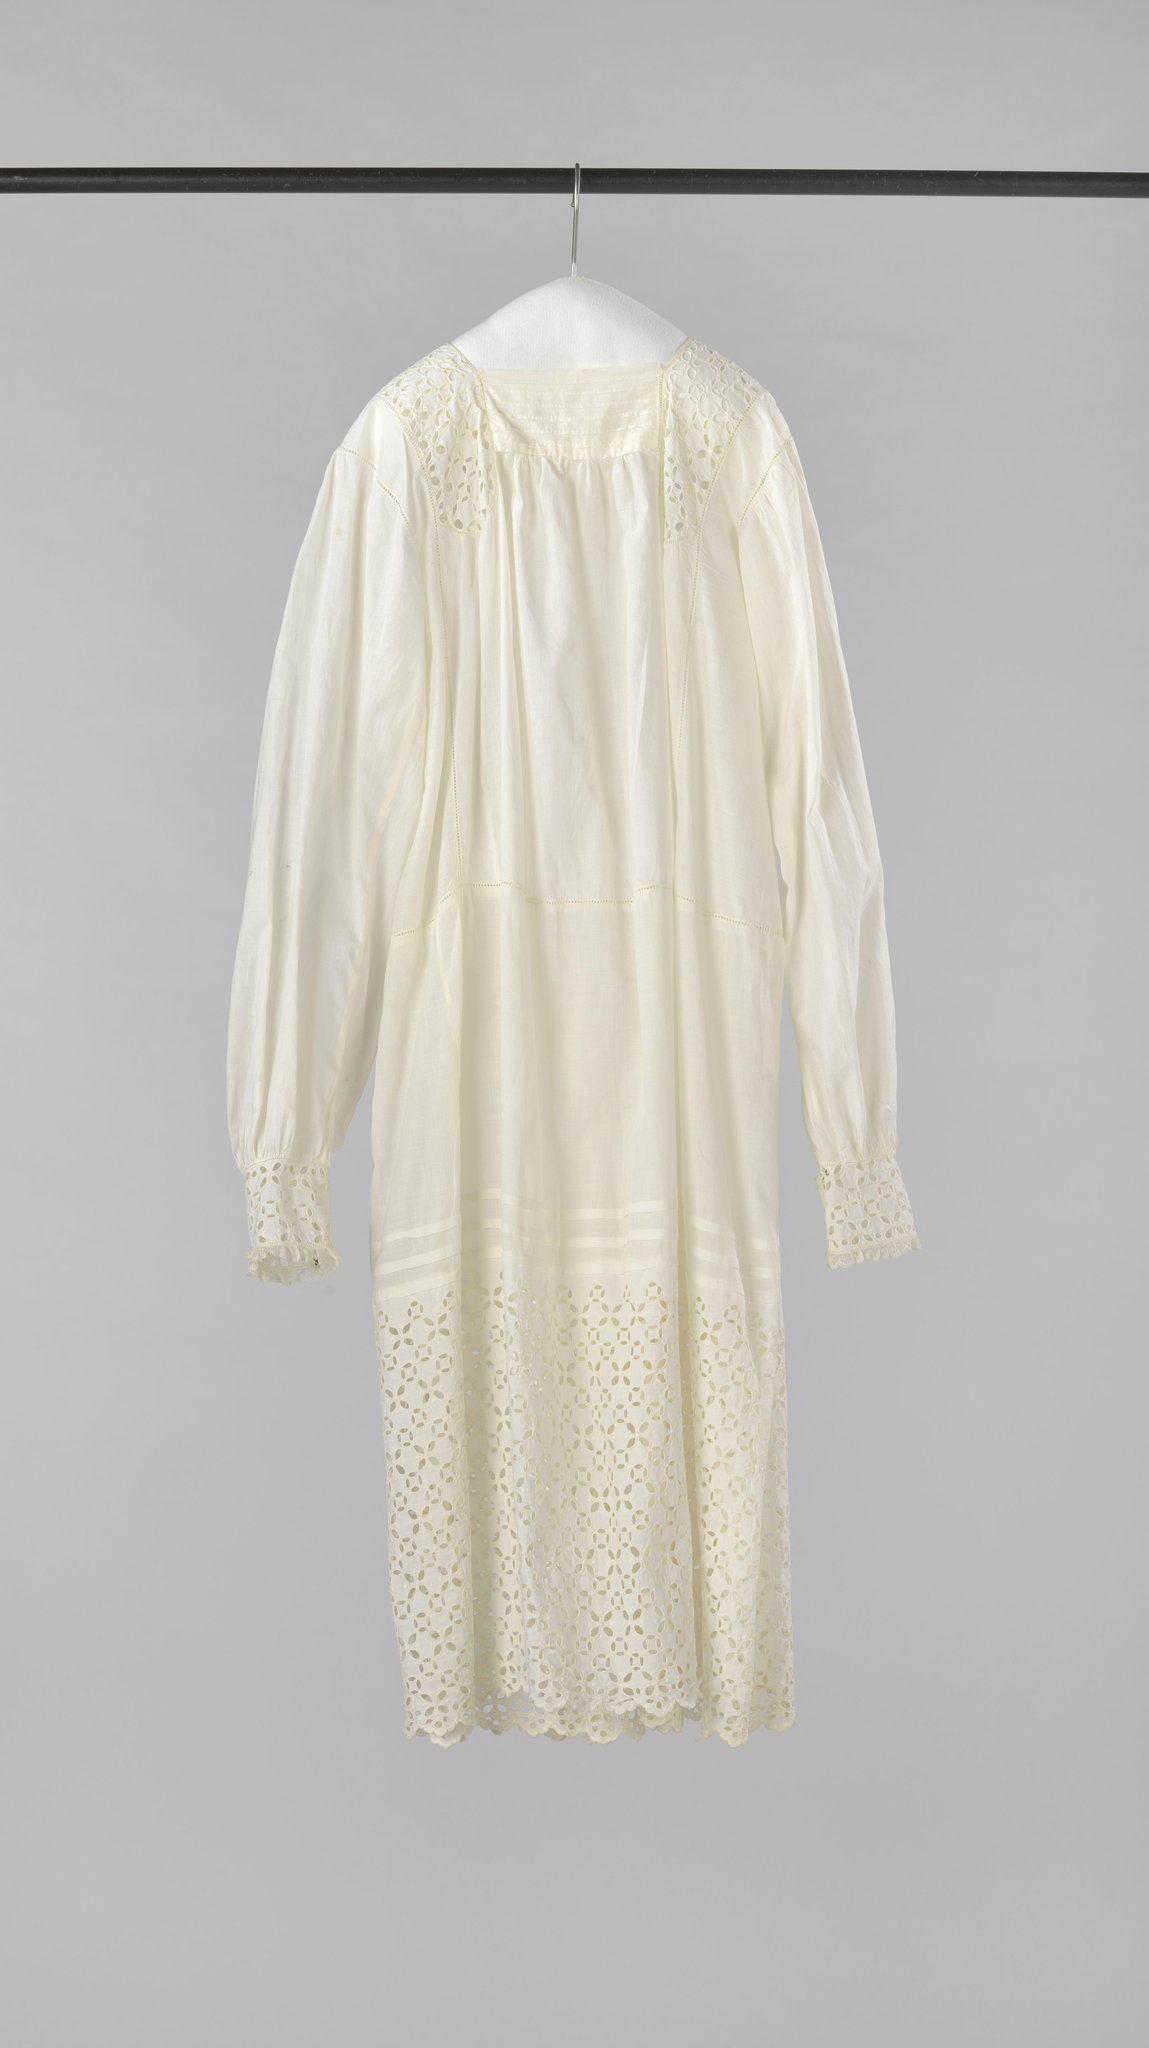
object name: childrenswear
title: Meisjesjurk met lange mouw, lage taille en achtersluiting van wit katoen, versierd met oprijgen, ajournaden en onderaan met een zeer brede strook Engels borduurwerk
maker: Anonymous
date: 1909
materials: cotton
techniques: embroidery, embroidered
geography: amsterdam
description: Jongmeisjesjurk van batist, genaaid met à-journaden en versierd met een zeer brede strook van machinaal Engels borduurwerk; te dragen met groen moiré lintceintuur. Jugendstil. Model: Lanvin-hemdmodel. Lang en wijd lijf met van voren en van achter een horzontale halspasje, met oprijgen tussen twee staande tussen zetsels van het Engels borduurwerk. Glad aangezette overhemdsmouwen met mauwsluitende, enkelvoudige manchet, weer van de broderie, achtersluiting met twee drukknoopjes in ht halspasje. Bijna glad aangezette, rechte rok met opruigjes en de borduurstrook , die glad aangezet is. Versiering. Staande à-journaden in het lijf, evenals in de taille. Patroon vh Eng. borduurwerk. Oneindig patroon van ovale gaatjes die tot sterretjes of tot cirkels zijn gevormd, welke in aaneengesloten rijen boven elkaar staan. Alleen onderaan kleine schulpjes. Toestand: Gewassen in 1979.